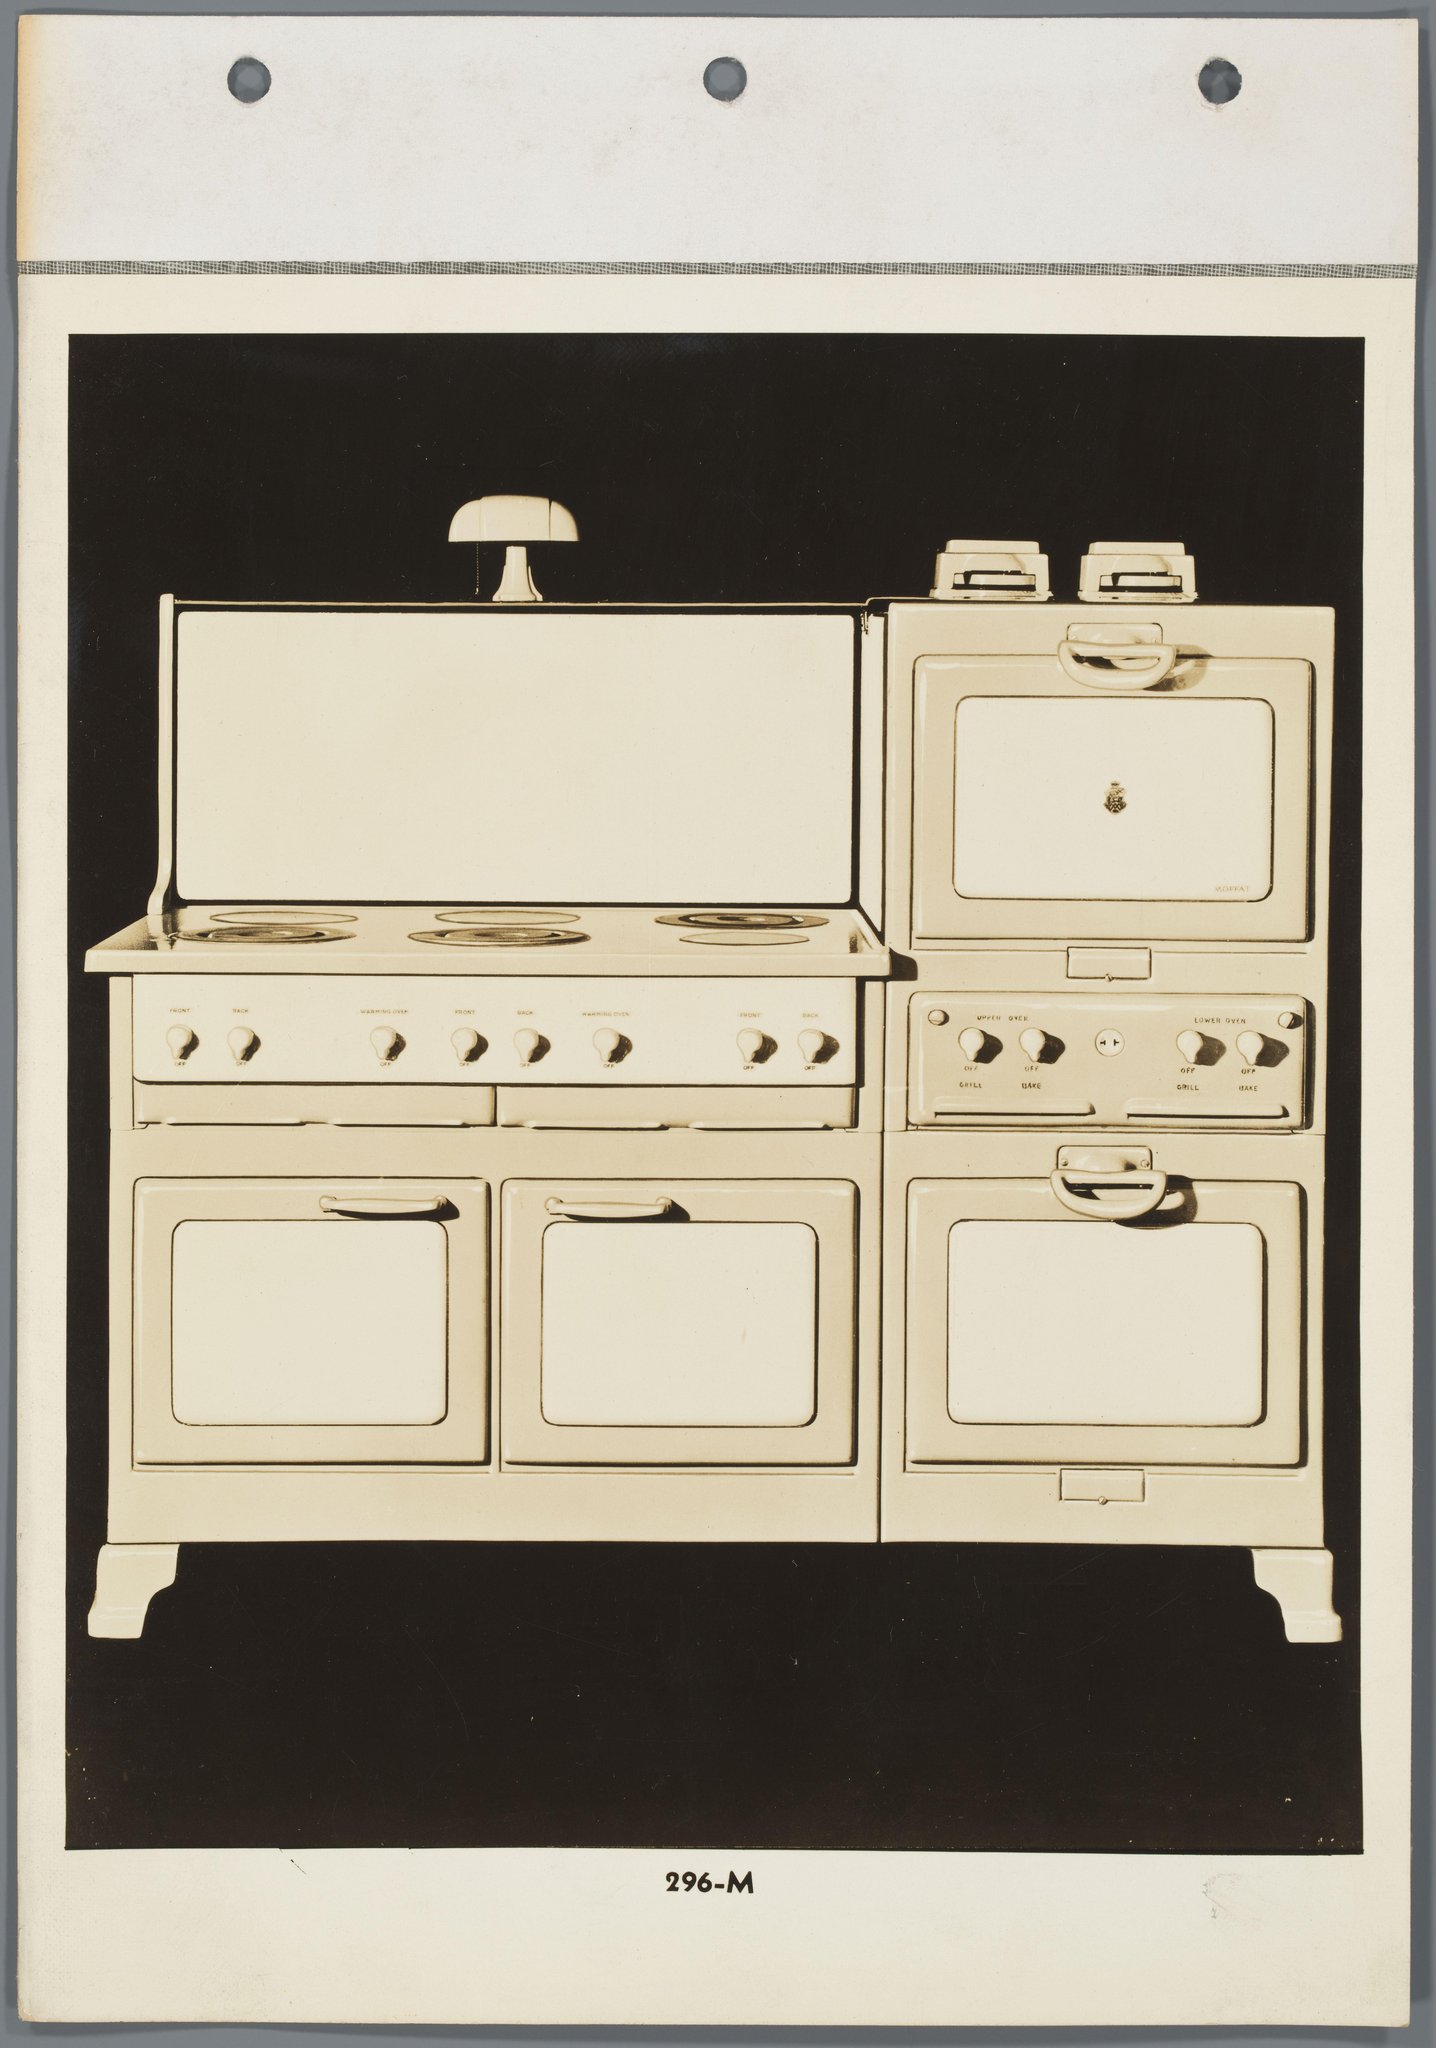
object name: photograph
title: Foto van Moffat ovens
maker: Anonymous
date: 1935-1940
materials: paper, photographic support, textile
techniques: gelatin silver print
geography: canada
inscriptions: inscription: ‘296-M’